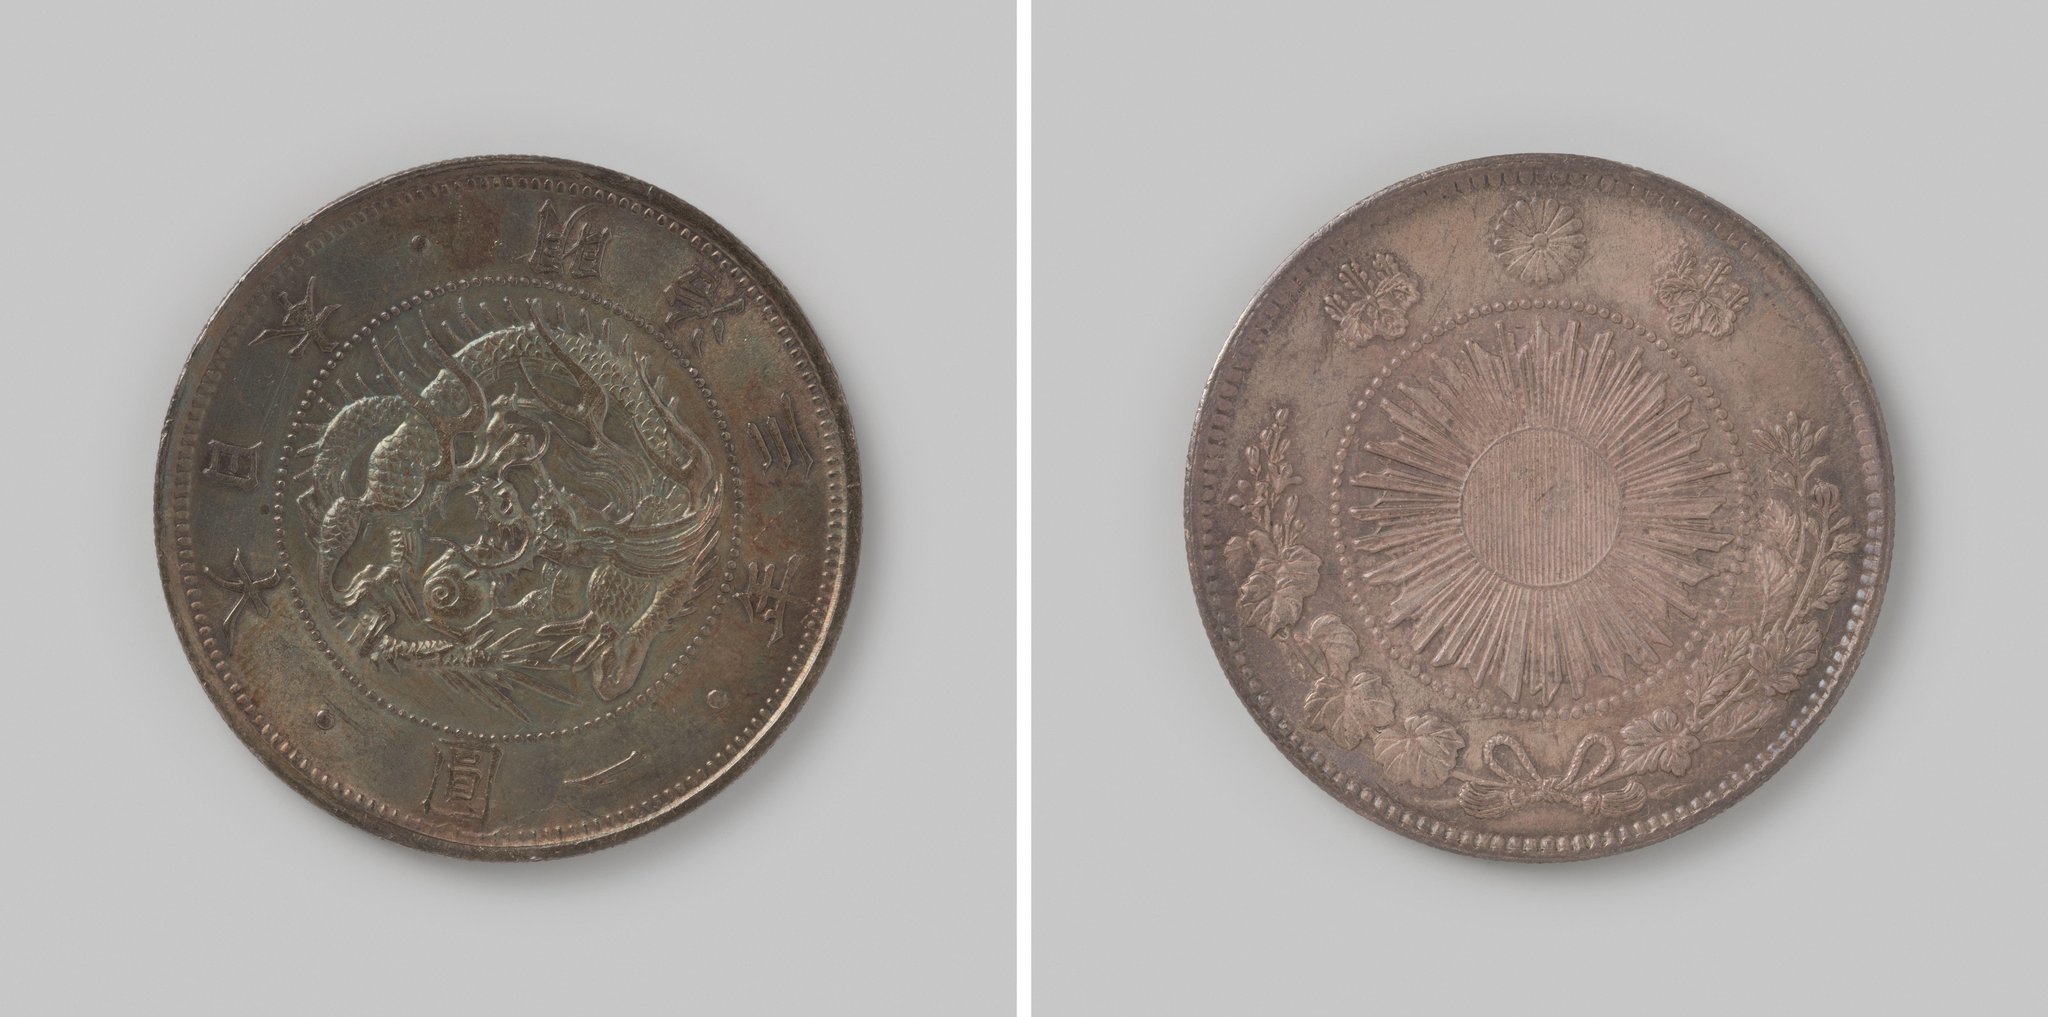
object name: coin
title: Yen van het keizerrijk Japan, uit het Meiji tijdperk, regeringsjaar 3 [=1870]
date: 1870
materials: silver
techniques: striking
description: Zilveren munt. Voorzijde: binnen cirkel gestileerde draak met in omschrift onderaan waarde-aanduiding: een, aangegeven door een liggende streep. Keerzijde: tussen twee samengebonden takken, waarboven symbolen, binnen cirkel zon met stralen. Kartelrand.